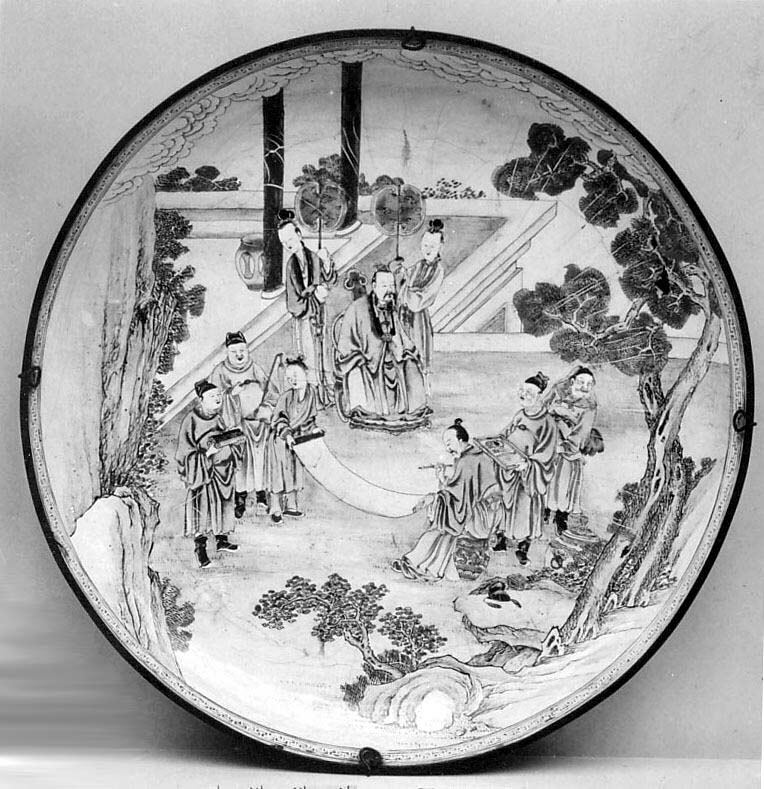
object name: dish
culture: chinese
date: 1736-1795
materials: enamel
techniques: painting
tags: men,trees